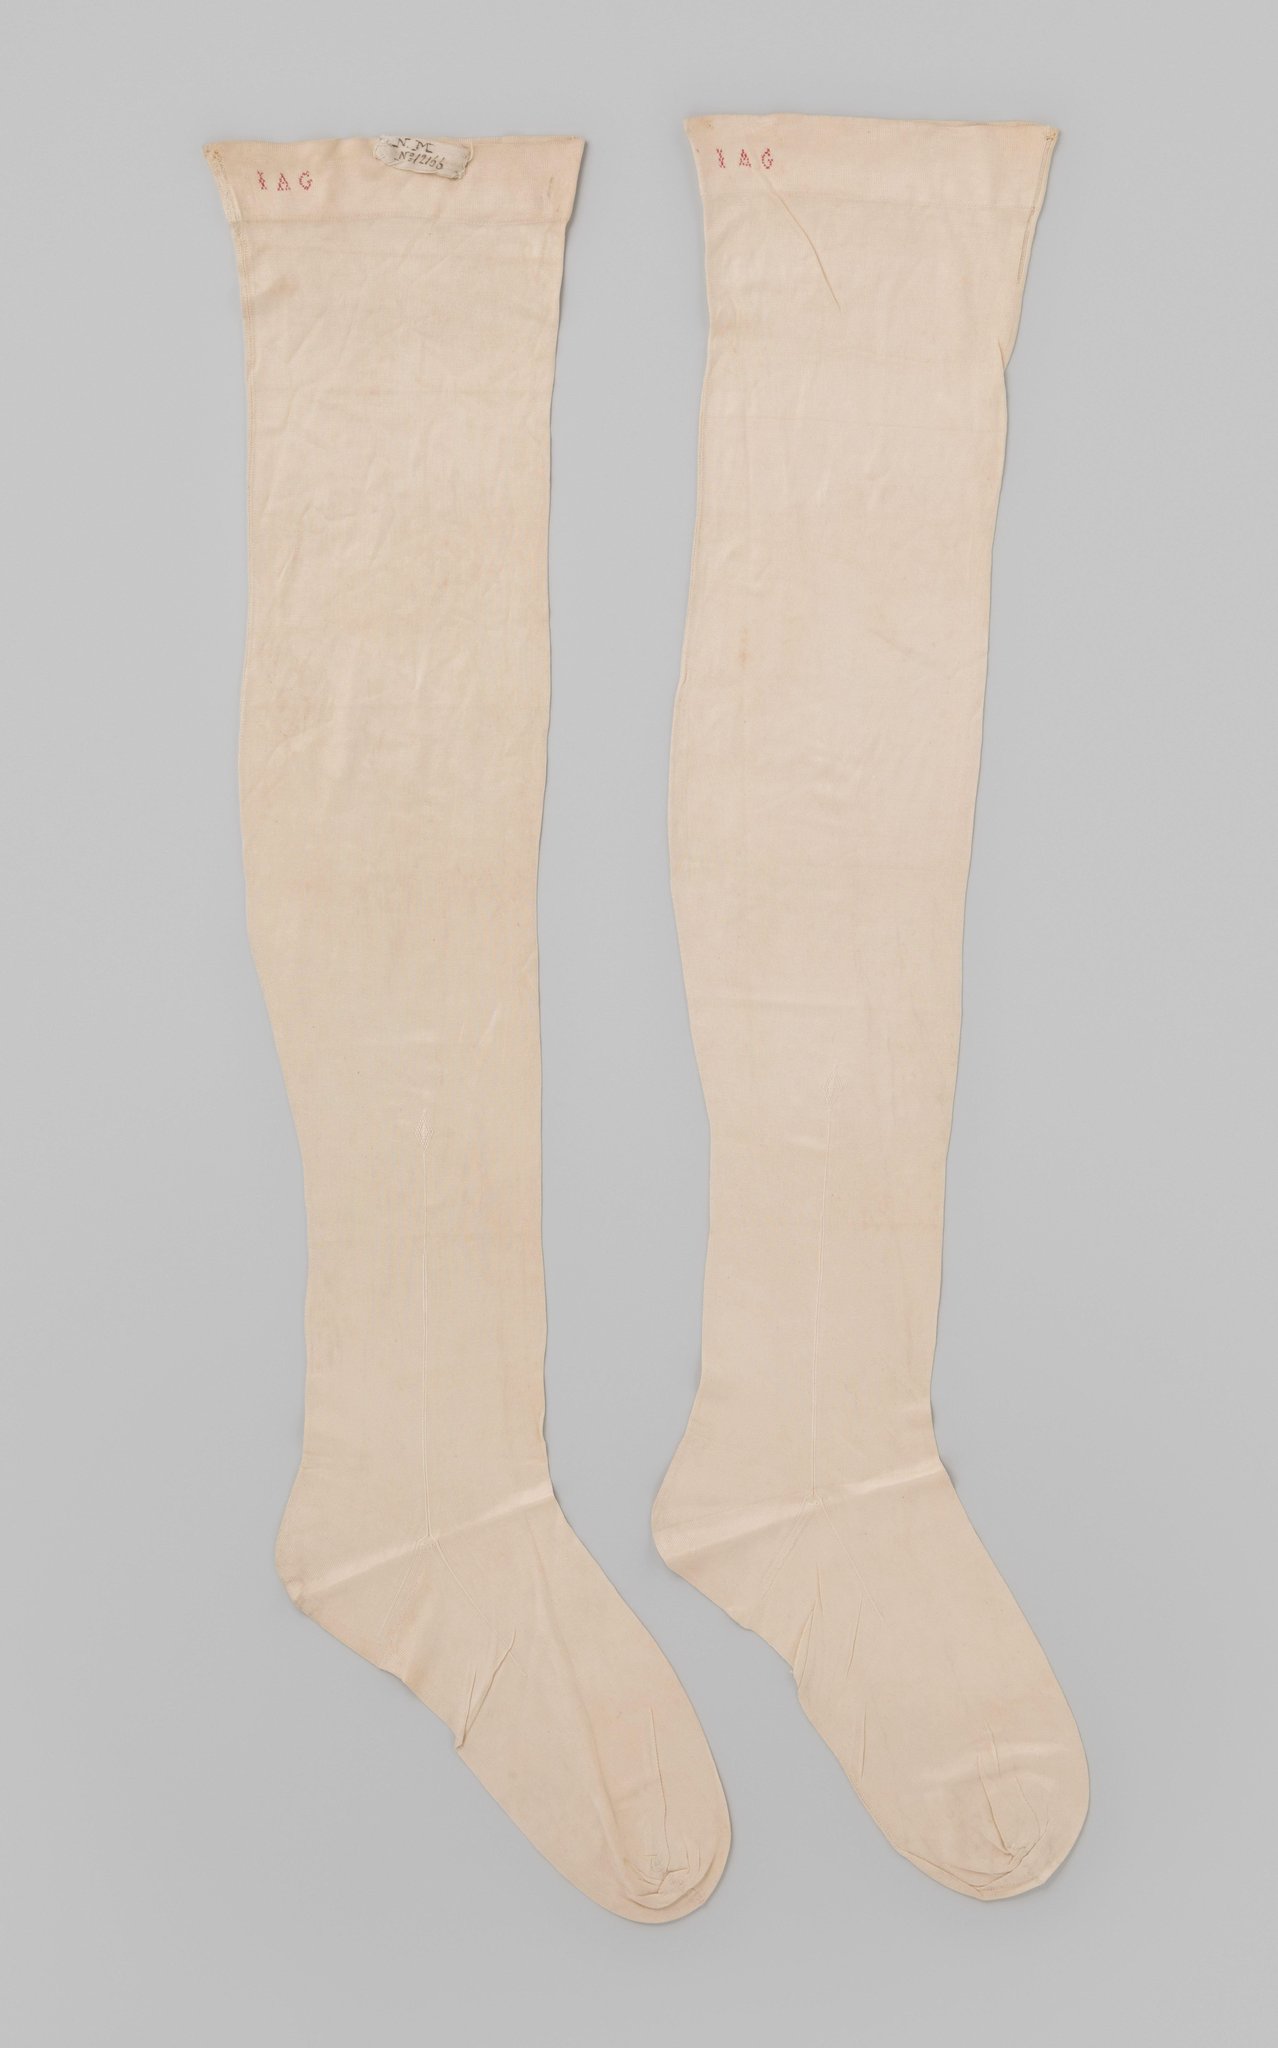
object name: clothing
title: Kous gebreid van effen witte zijde, met langs de klink een geborduurde lijn, uitlopend in een diamantvorm, op de boord in rood in kruissteek 'I.A.G'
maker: Anonymous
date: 1800-1820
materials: silk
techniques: cross stitching, embroidered, knitting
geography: netherlands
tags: vught, overveen, minister, staatsman, intendant-generaal van financien, secretaris van staat voor financien, minister van financiën, izaak jean alexandre gogel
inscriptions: initials: ‘'I.A.G'’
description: Kous gebreid van effen witte zijde, met langs de klink een geborduurde lijn, uitlopend in een diamantvorm. Naad middenachter. Op de boord in rood in kruissteek 'I.A.G'.